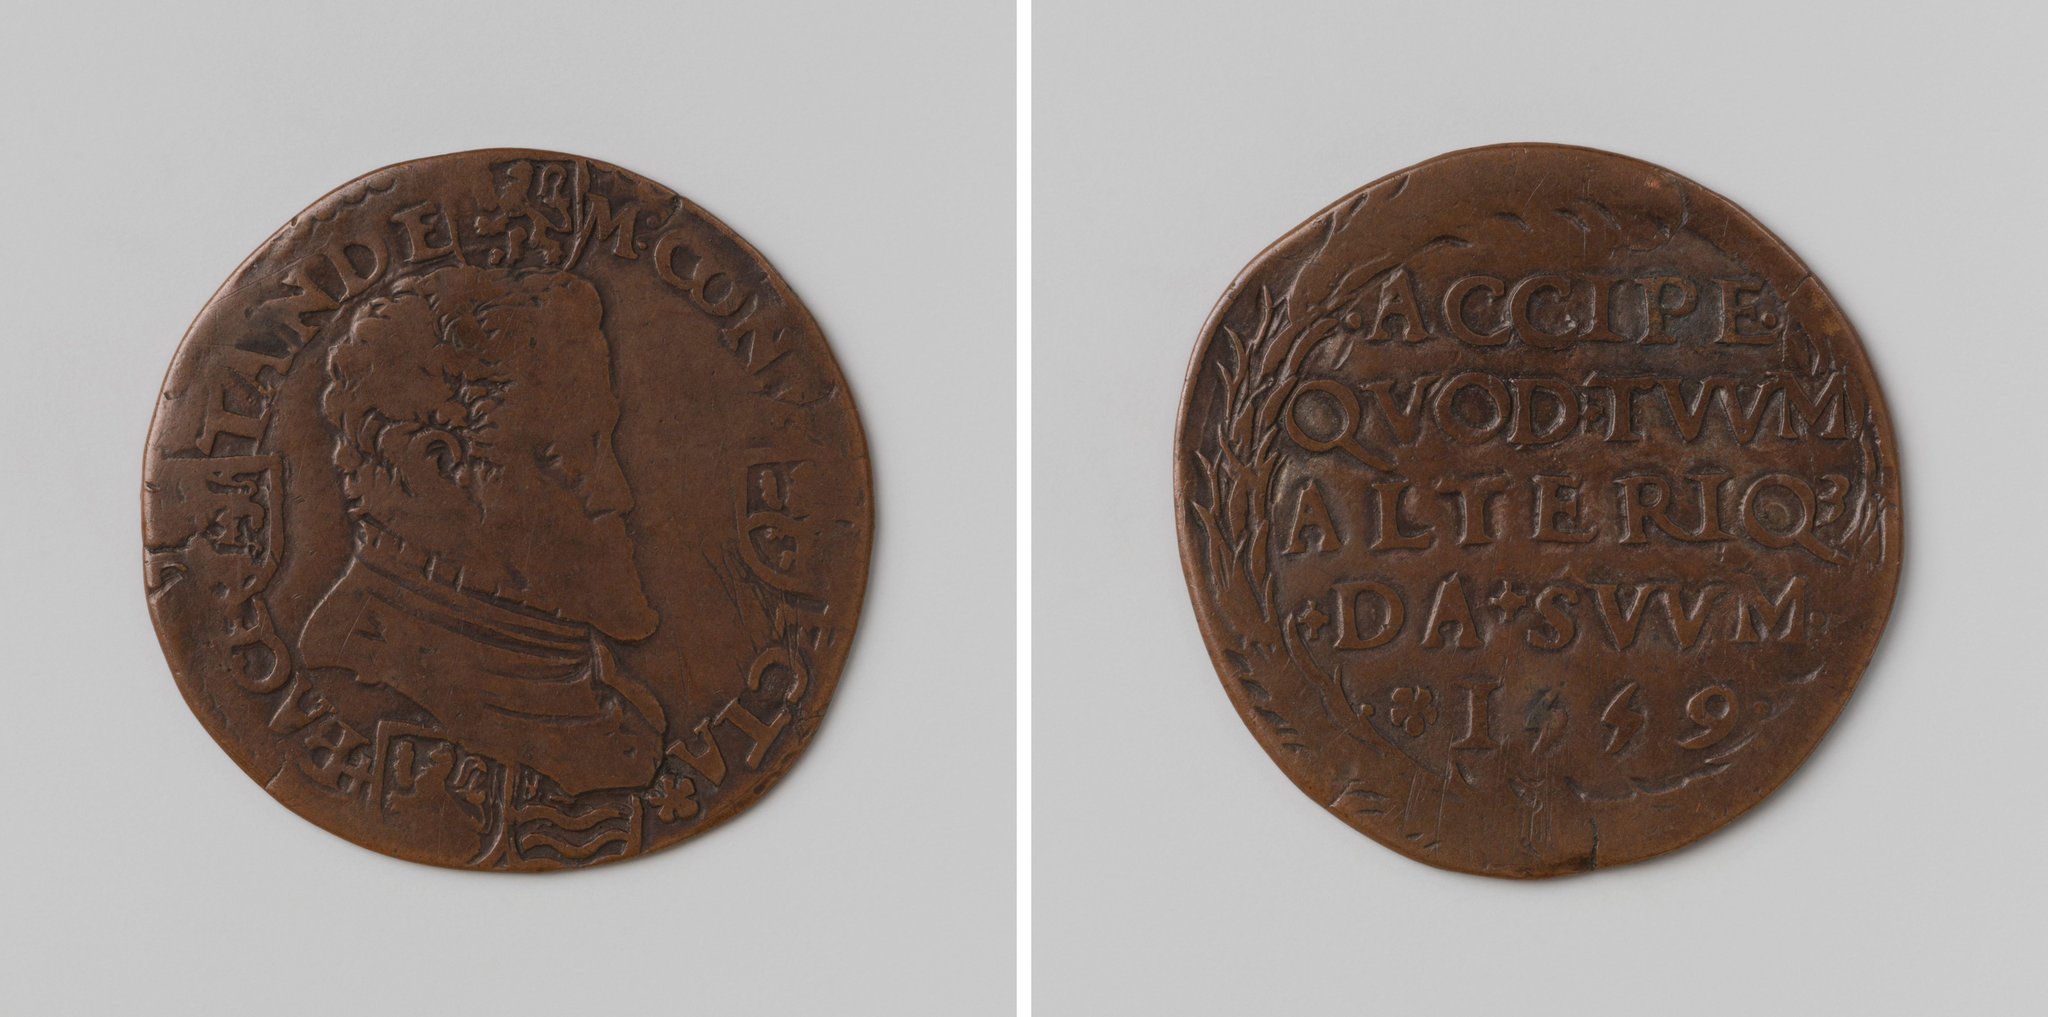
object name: jeton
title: Vrede van Le Cateau-Cambresis, ter ere van Filips II, koning van Spanje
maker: Anonymous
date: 1559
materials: copper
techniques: striking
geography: netherlands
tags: philip ii of spain, zeeland, utrecht, holland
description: Koperen penning. Voorzijde: borststuk man binnen omschrift, onderbroken door vijf wapenschilden. Keerzijde: opschrift binnen lauwerkrans